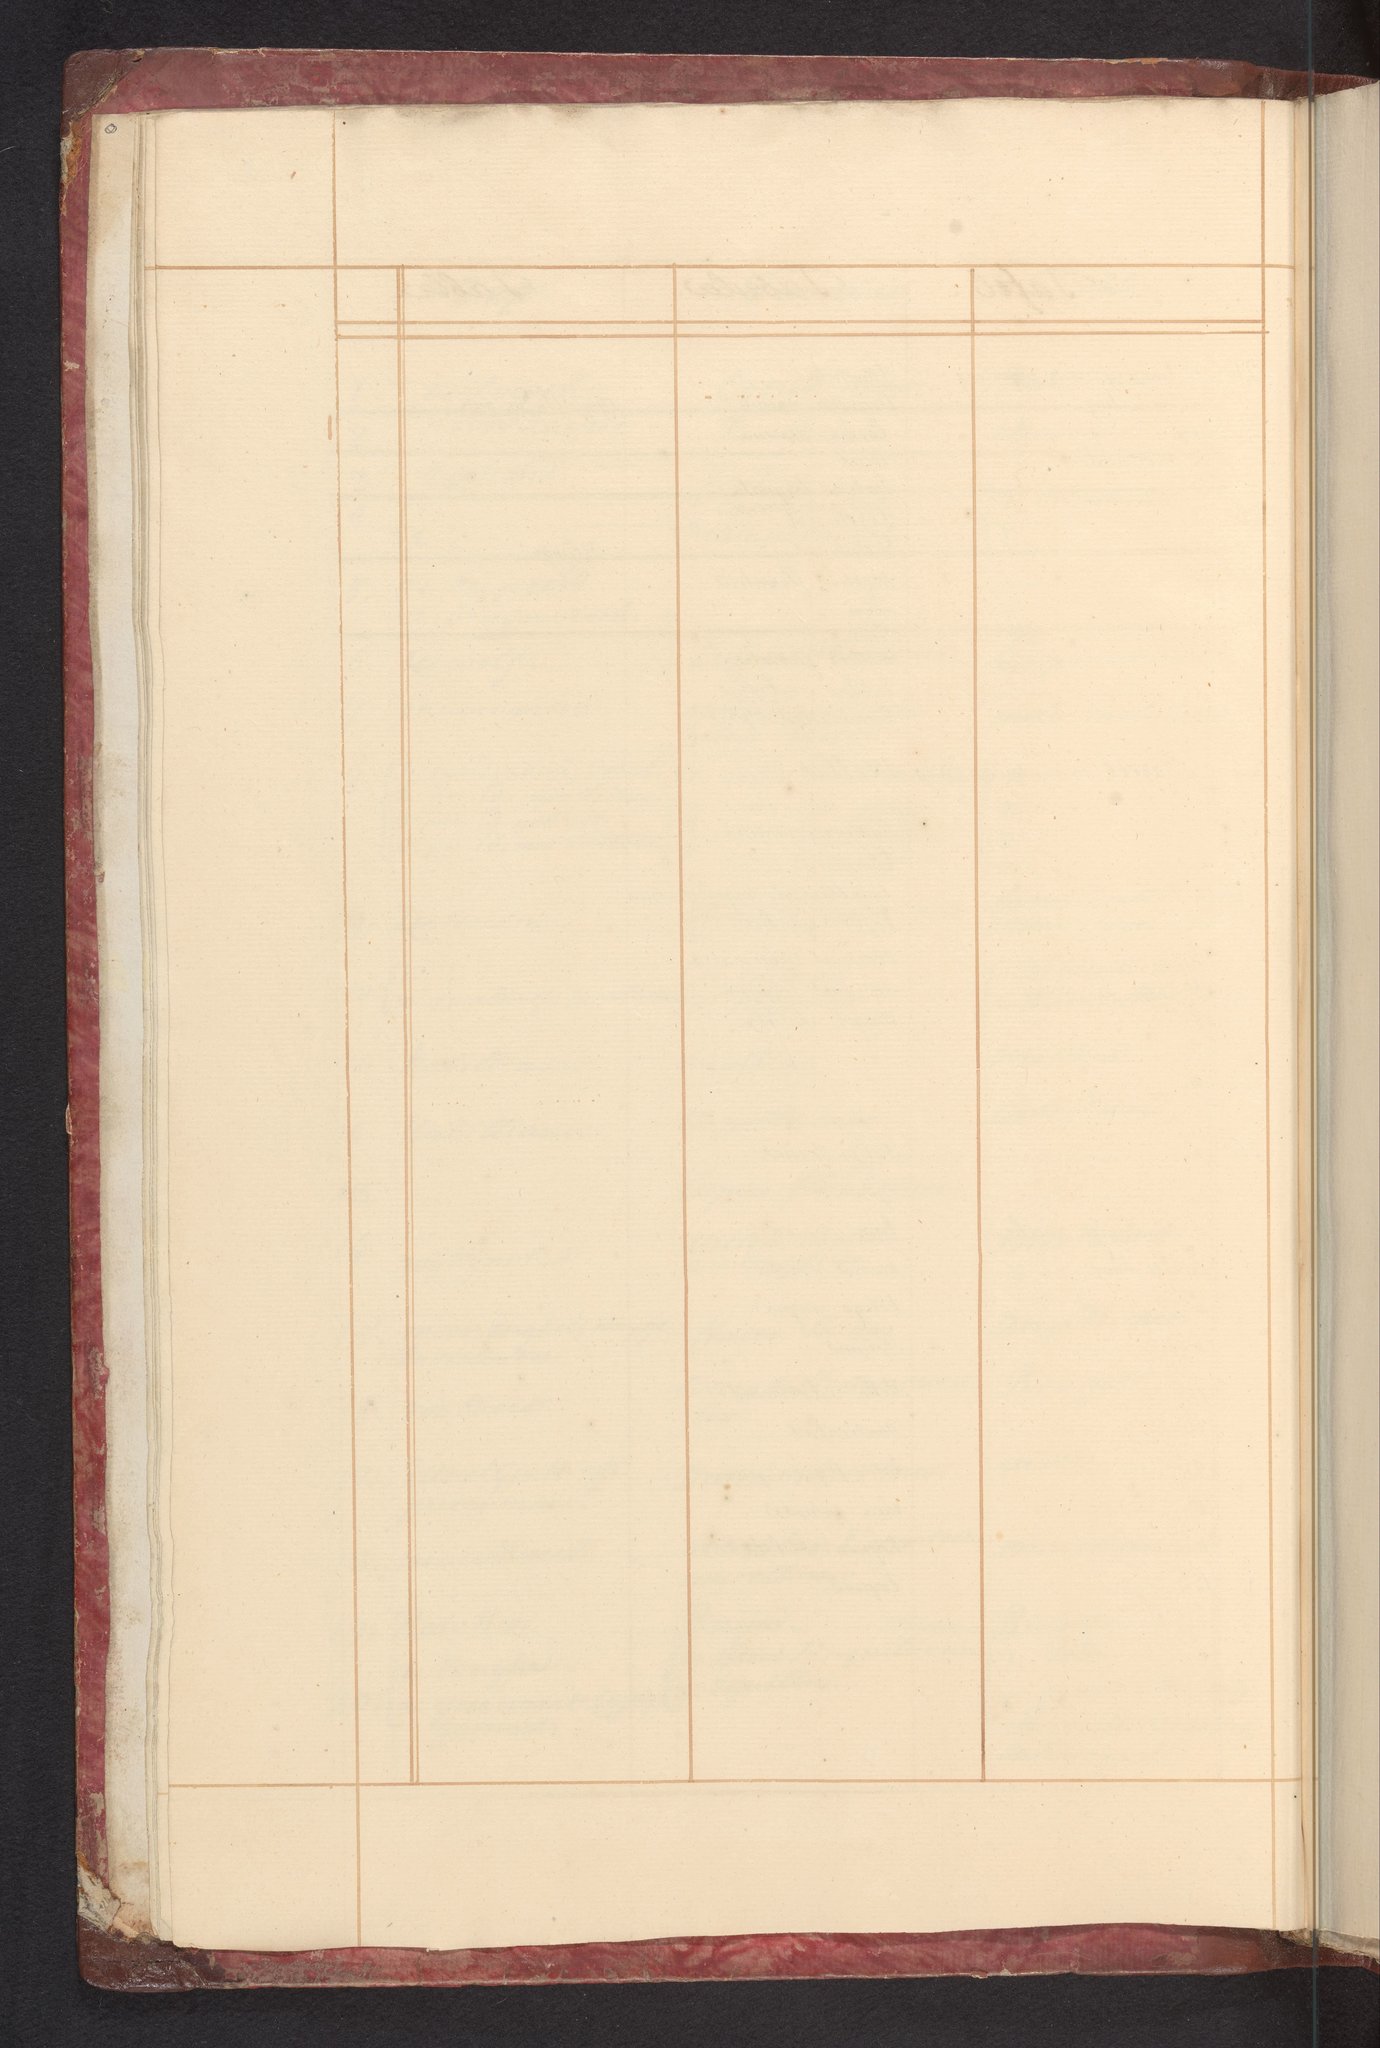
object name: manuscript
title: Oningevuld schema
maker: joseph van huerne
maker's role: kunstliefhebber, mecenas, verzamelaar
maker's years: 1752-1844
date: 1809-1814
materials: ink, paper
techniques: pen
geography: bruges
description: Oningevuld schema met drie kolommen. Onderdeel van het zesde album met tekeningen van vissen, schelpen en insekten. Zesde van twaalf albums met tekeningen van dieren, vogels en planten bekend rond 1600, gemaakt in opdracht van keizer Rudolf II. Met toelichting in Nederlands, Latijn en Frans.